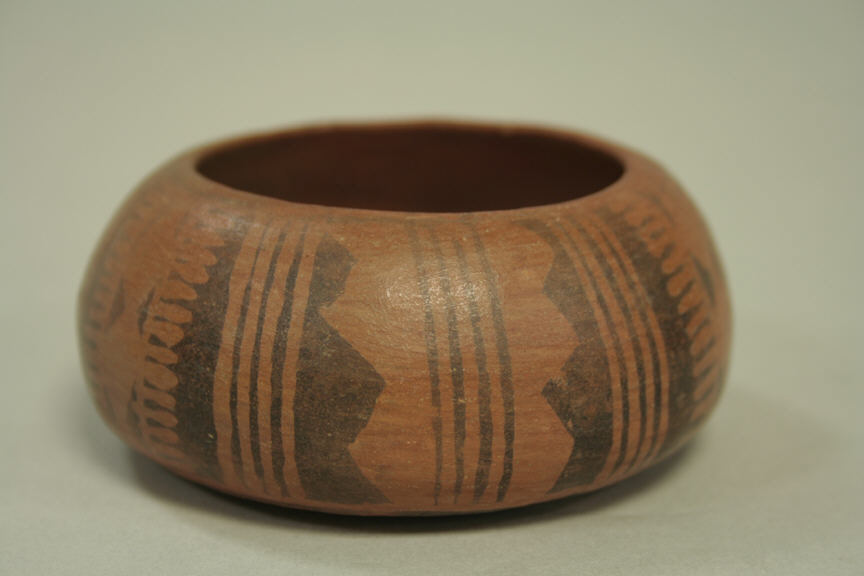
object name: bowl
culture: paracas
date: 200-1 BCE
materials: ceramic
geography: peru